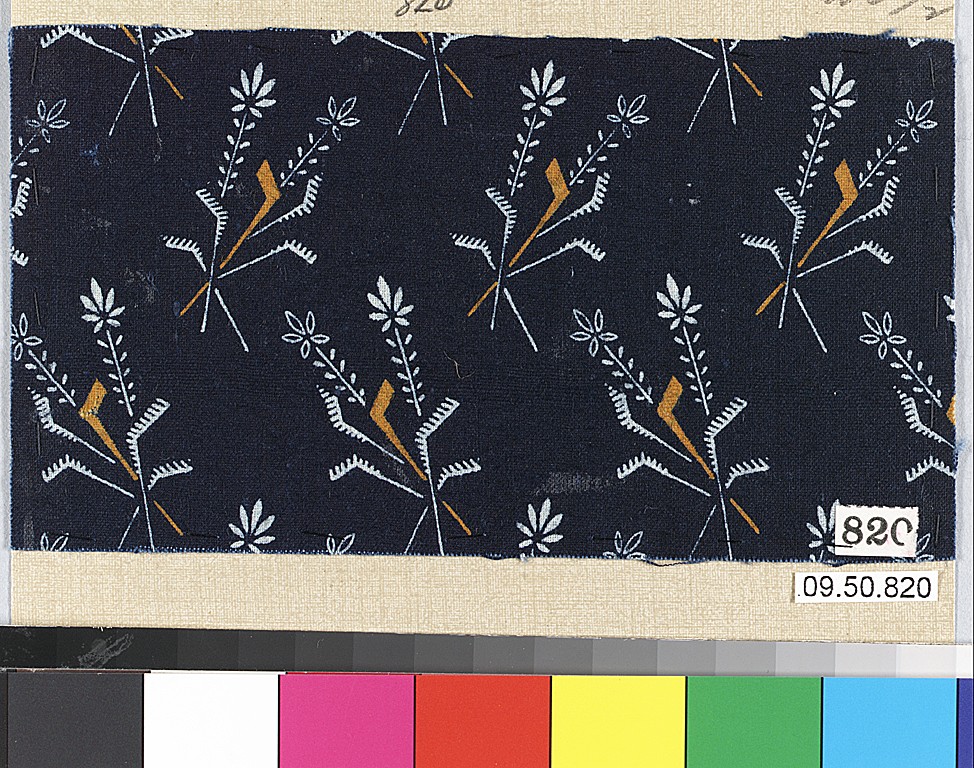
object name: piece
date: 1801-1900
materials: cotton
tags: leaves